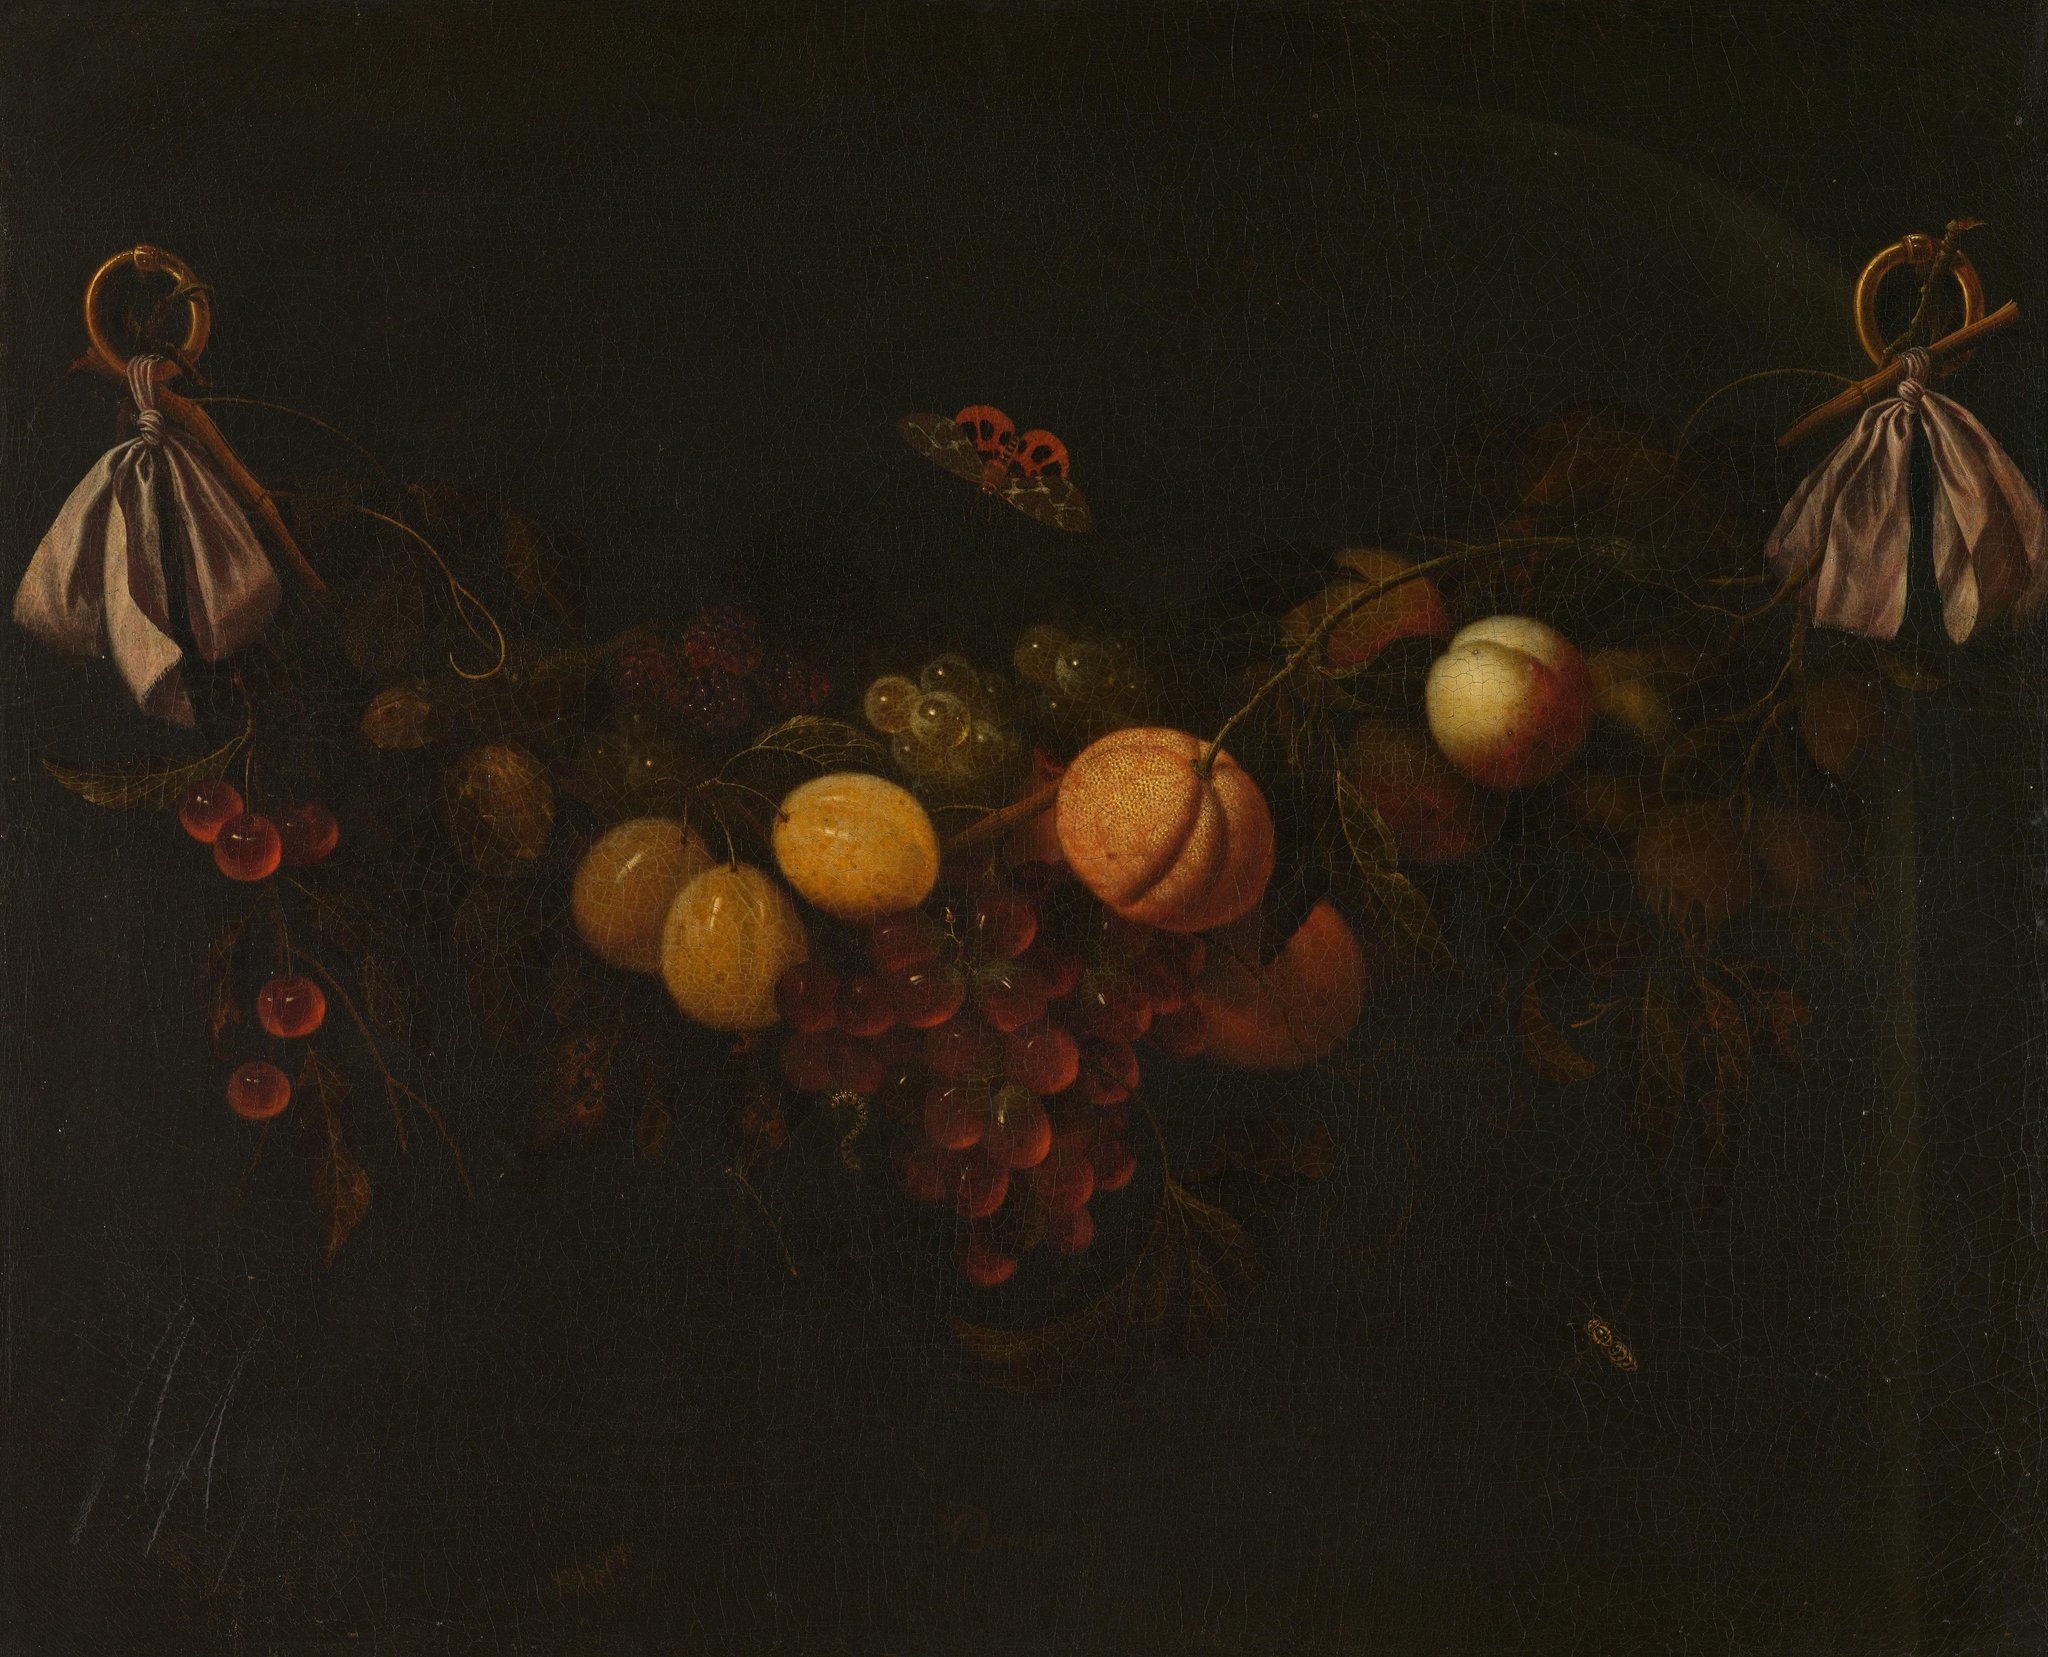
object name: painting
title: Festoon of Fruits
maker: johannes borman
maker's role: painter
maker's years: -1659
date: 1653-1658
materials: canvas, oil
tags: fruit, ornament ~ festoon, garland, fruits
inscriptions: signature: ‘Borman f.’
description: Festoen van verschillende vruchten, waaronder druiven, abrikozen, sinaasappels en perziken. Om de vruchten vliegen een vlinder en een wesp.